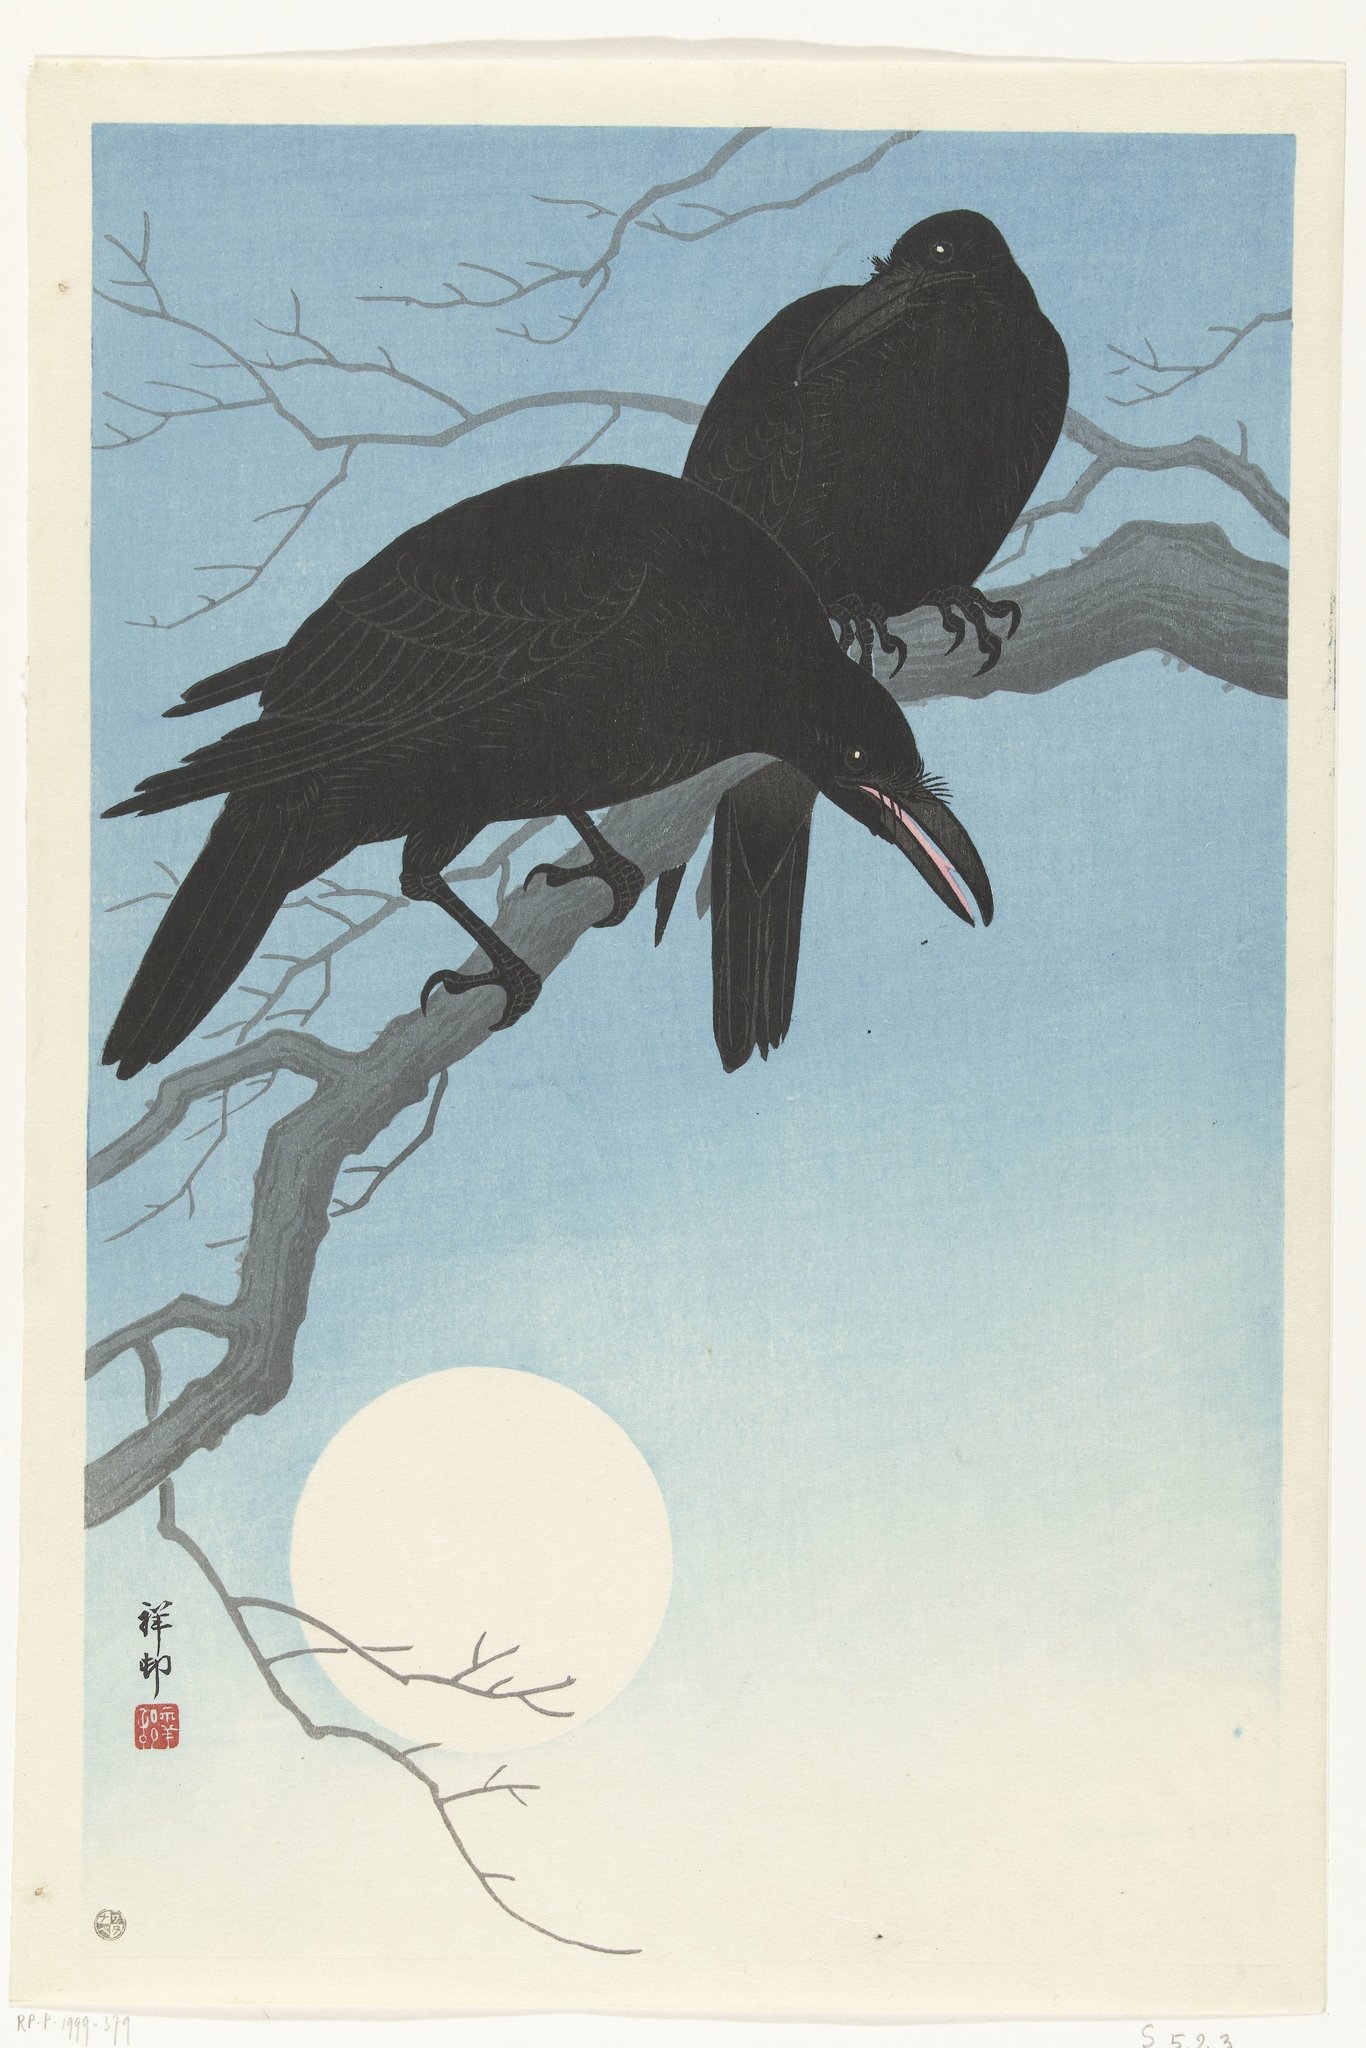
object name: print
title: Twee kraaien op een tak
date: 1927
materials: paper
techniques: woodcut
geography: tokyo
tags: full moon, song-birds: crow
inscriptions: collector's mark: Lugt 2228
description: Twee kraaien op een tak, bij volle maan.